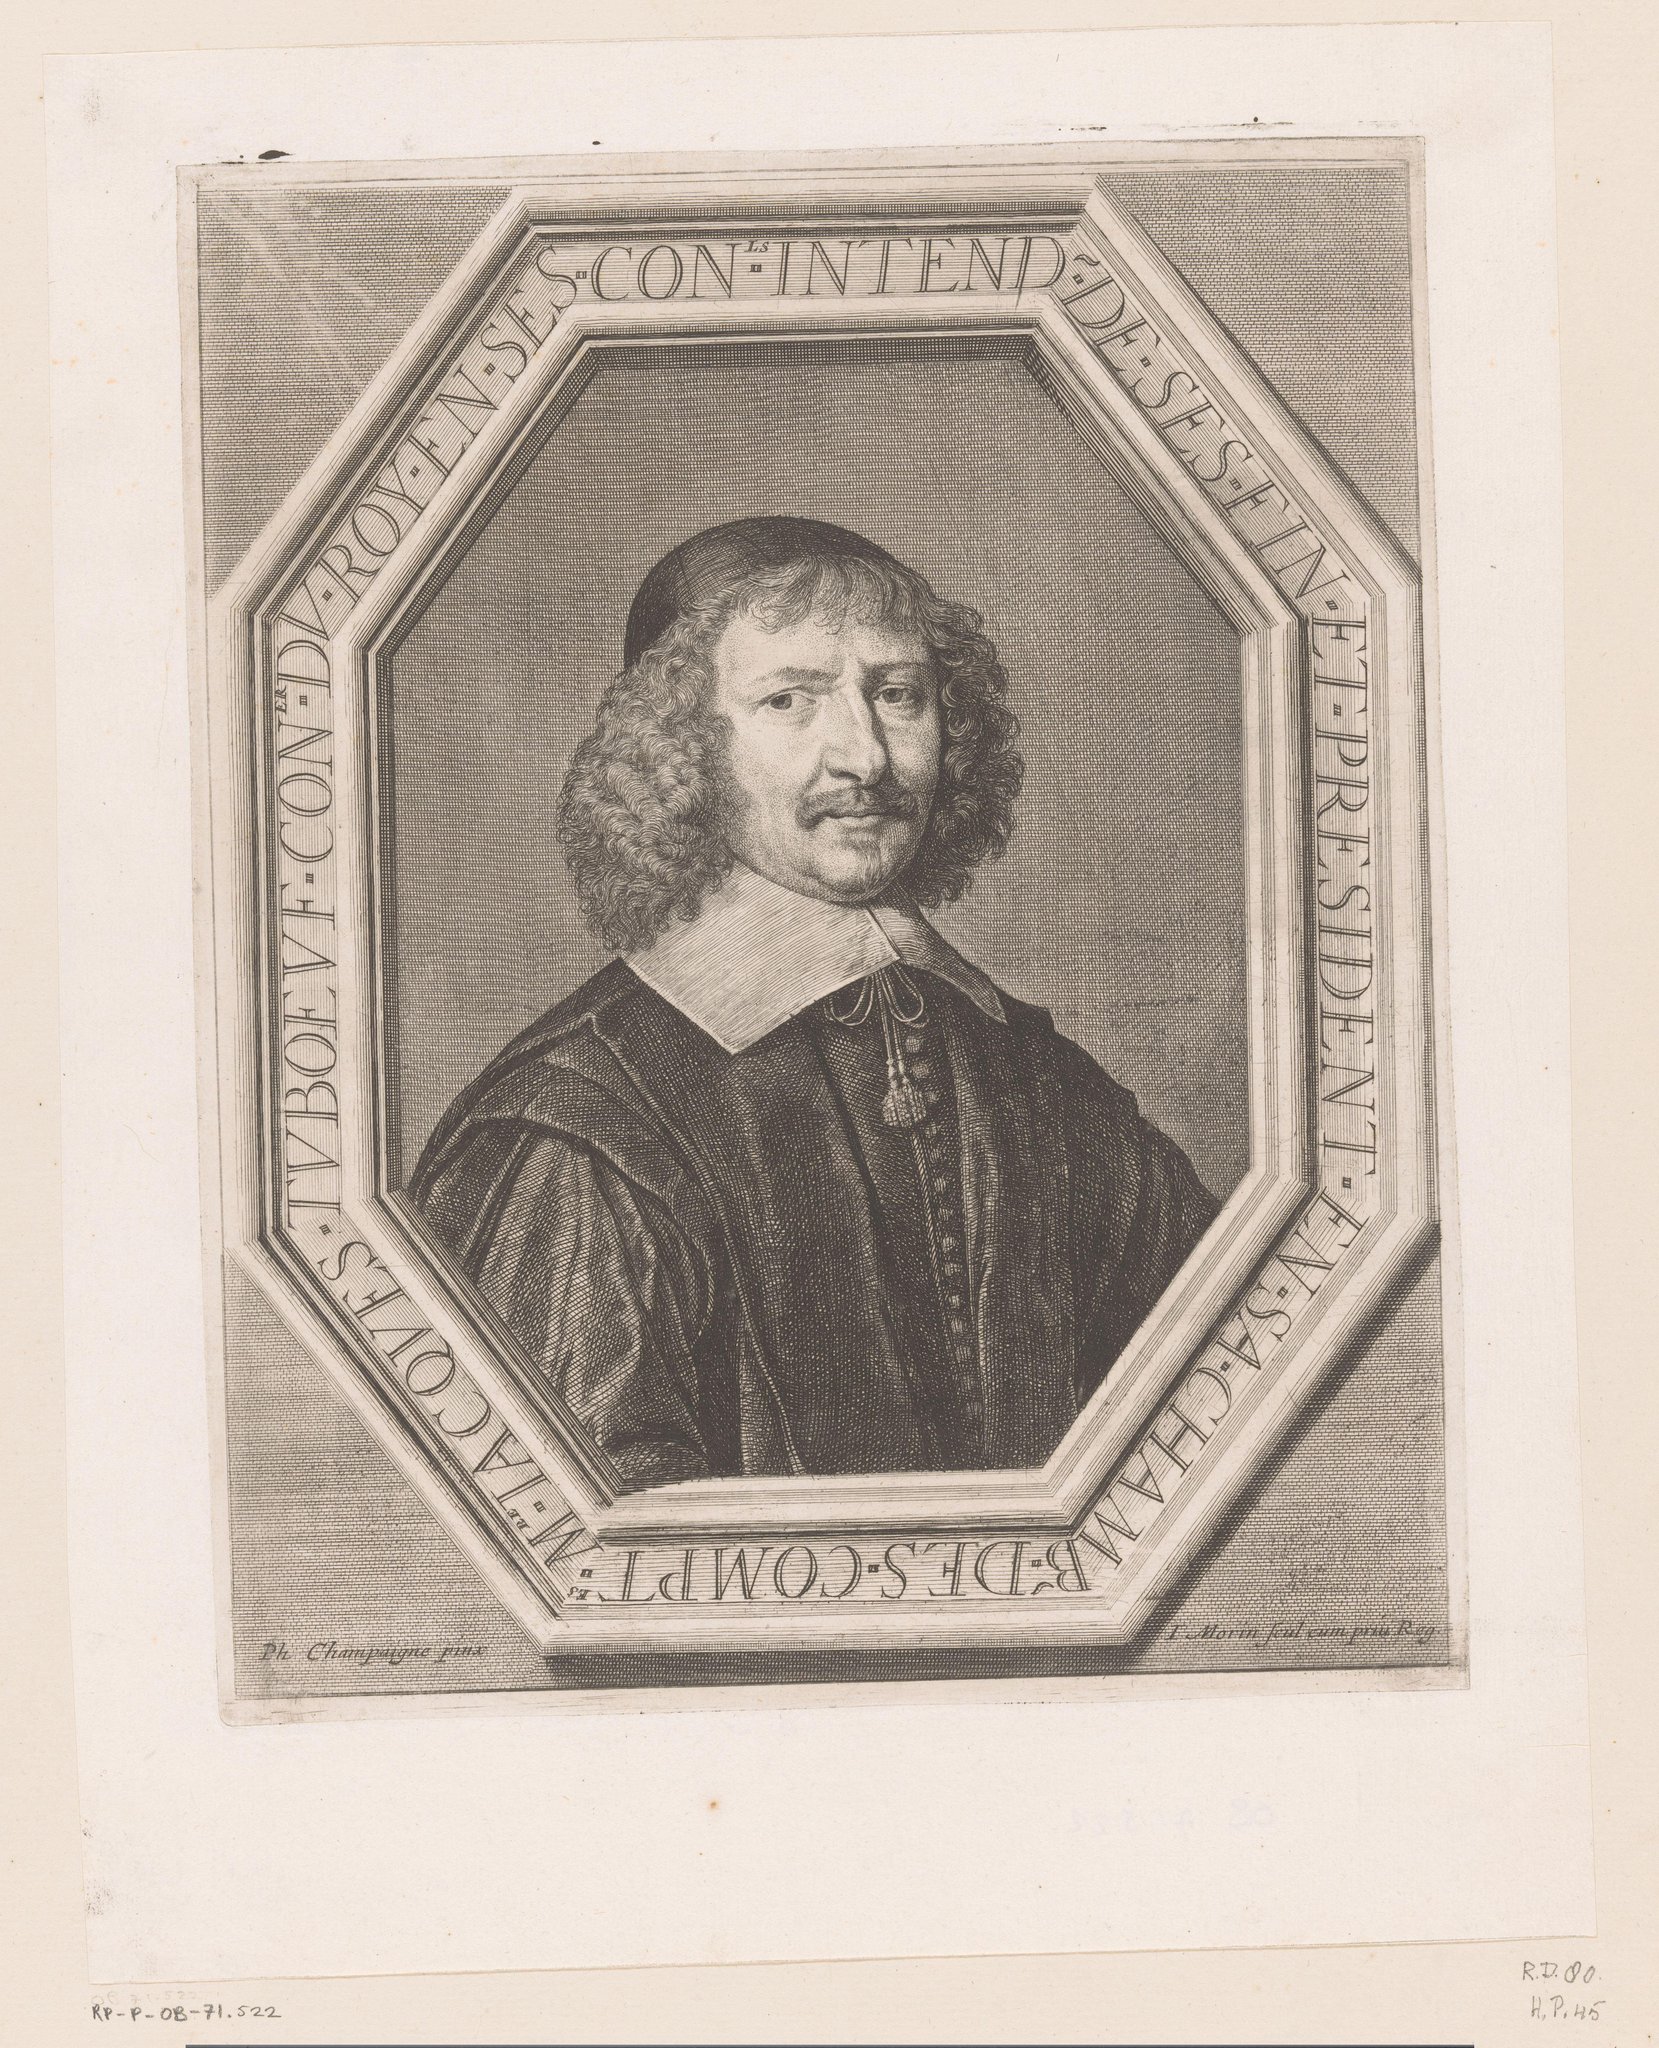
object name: print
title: Portret van Jacques Tuboeuf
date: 1640-1650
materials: paper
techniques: etching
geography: france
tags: politician, historical persons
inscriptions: collector's mark: Lugt 2228